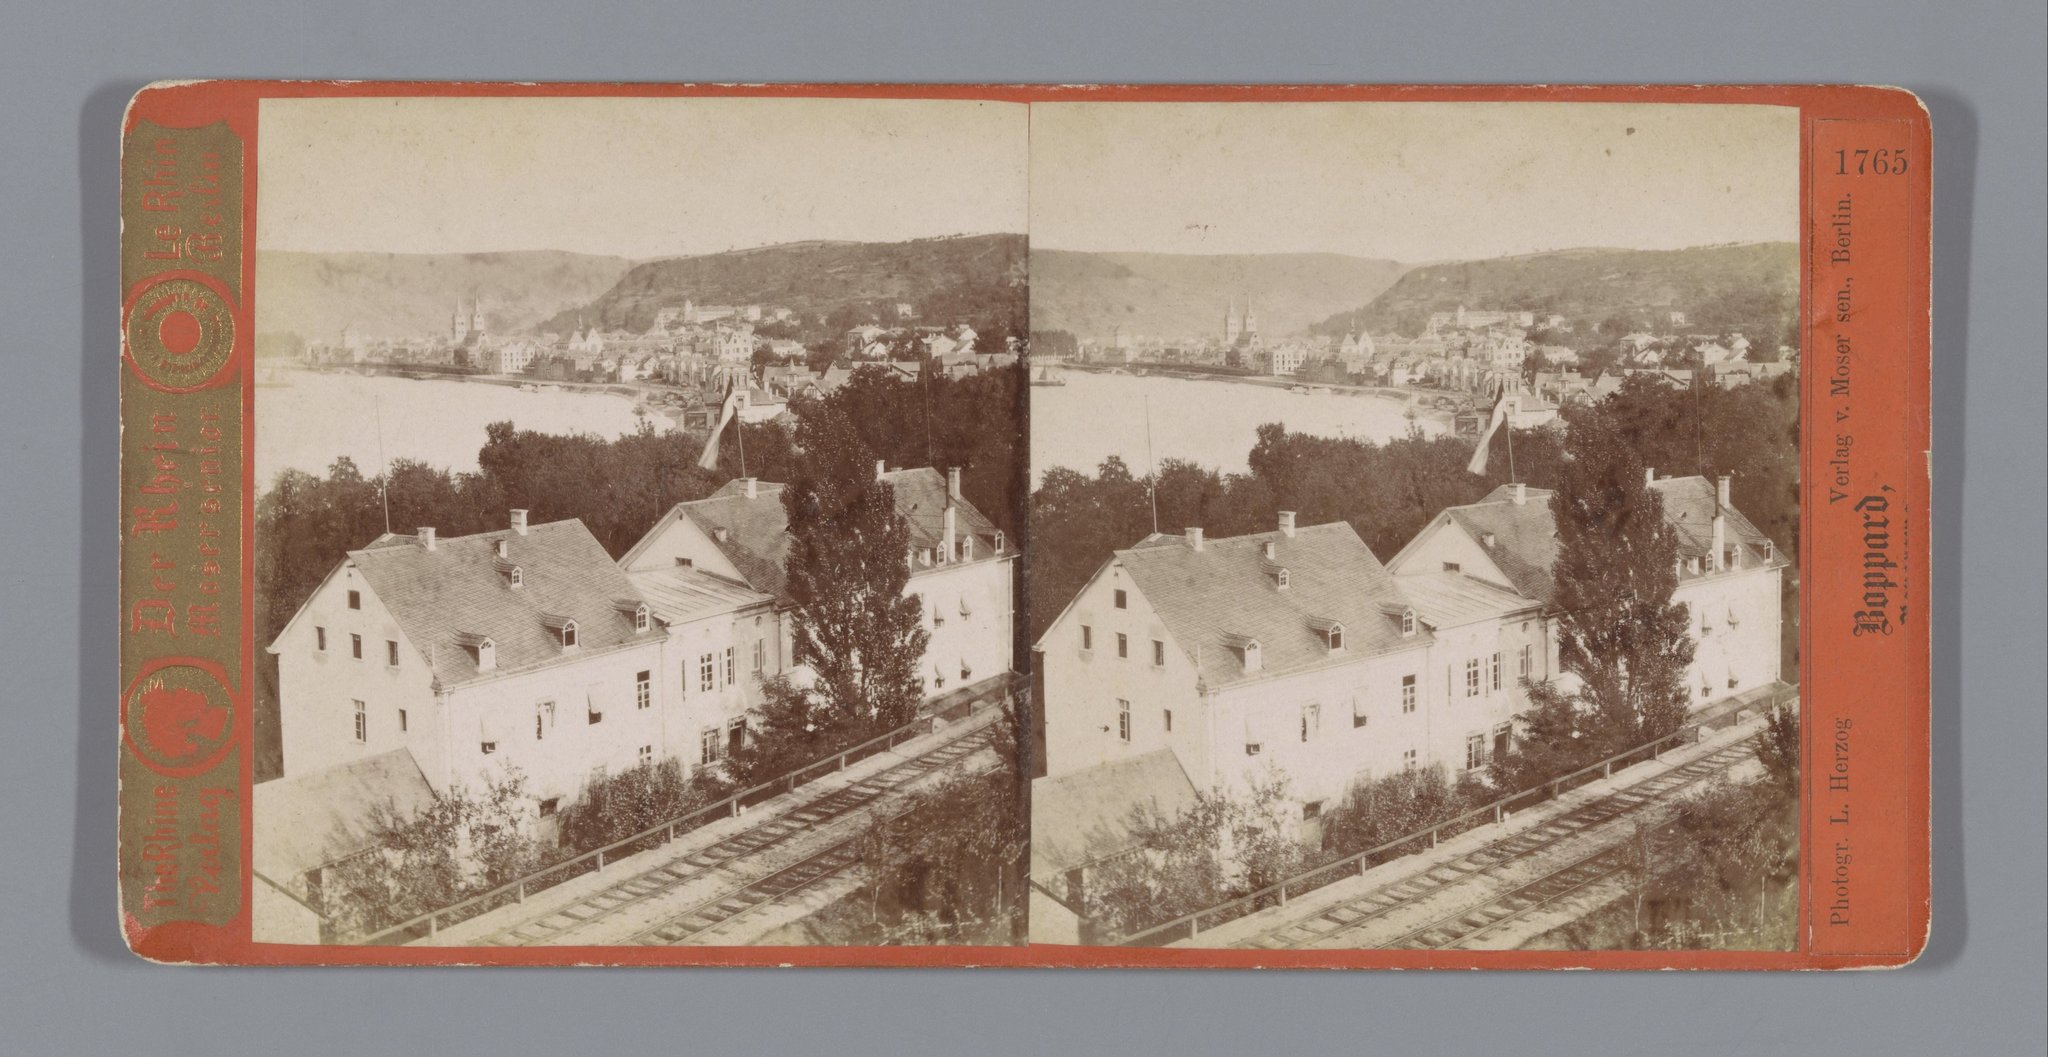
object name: stereograph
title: Der Rhein / The Rhine / Le Rhin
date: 1873-1890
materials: cardboard, paper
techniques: albumen print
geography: berlin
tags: city-view in general; 'veduta'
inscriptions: inscription: ‘Photographiser und Stereoscopischer/ Kunstverlag/ von/ Moser senior (...) Glas-u. Papier-Stereoscopbildern/ aller Weltgegenden’, number: ‘1765’